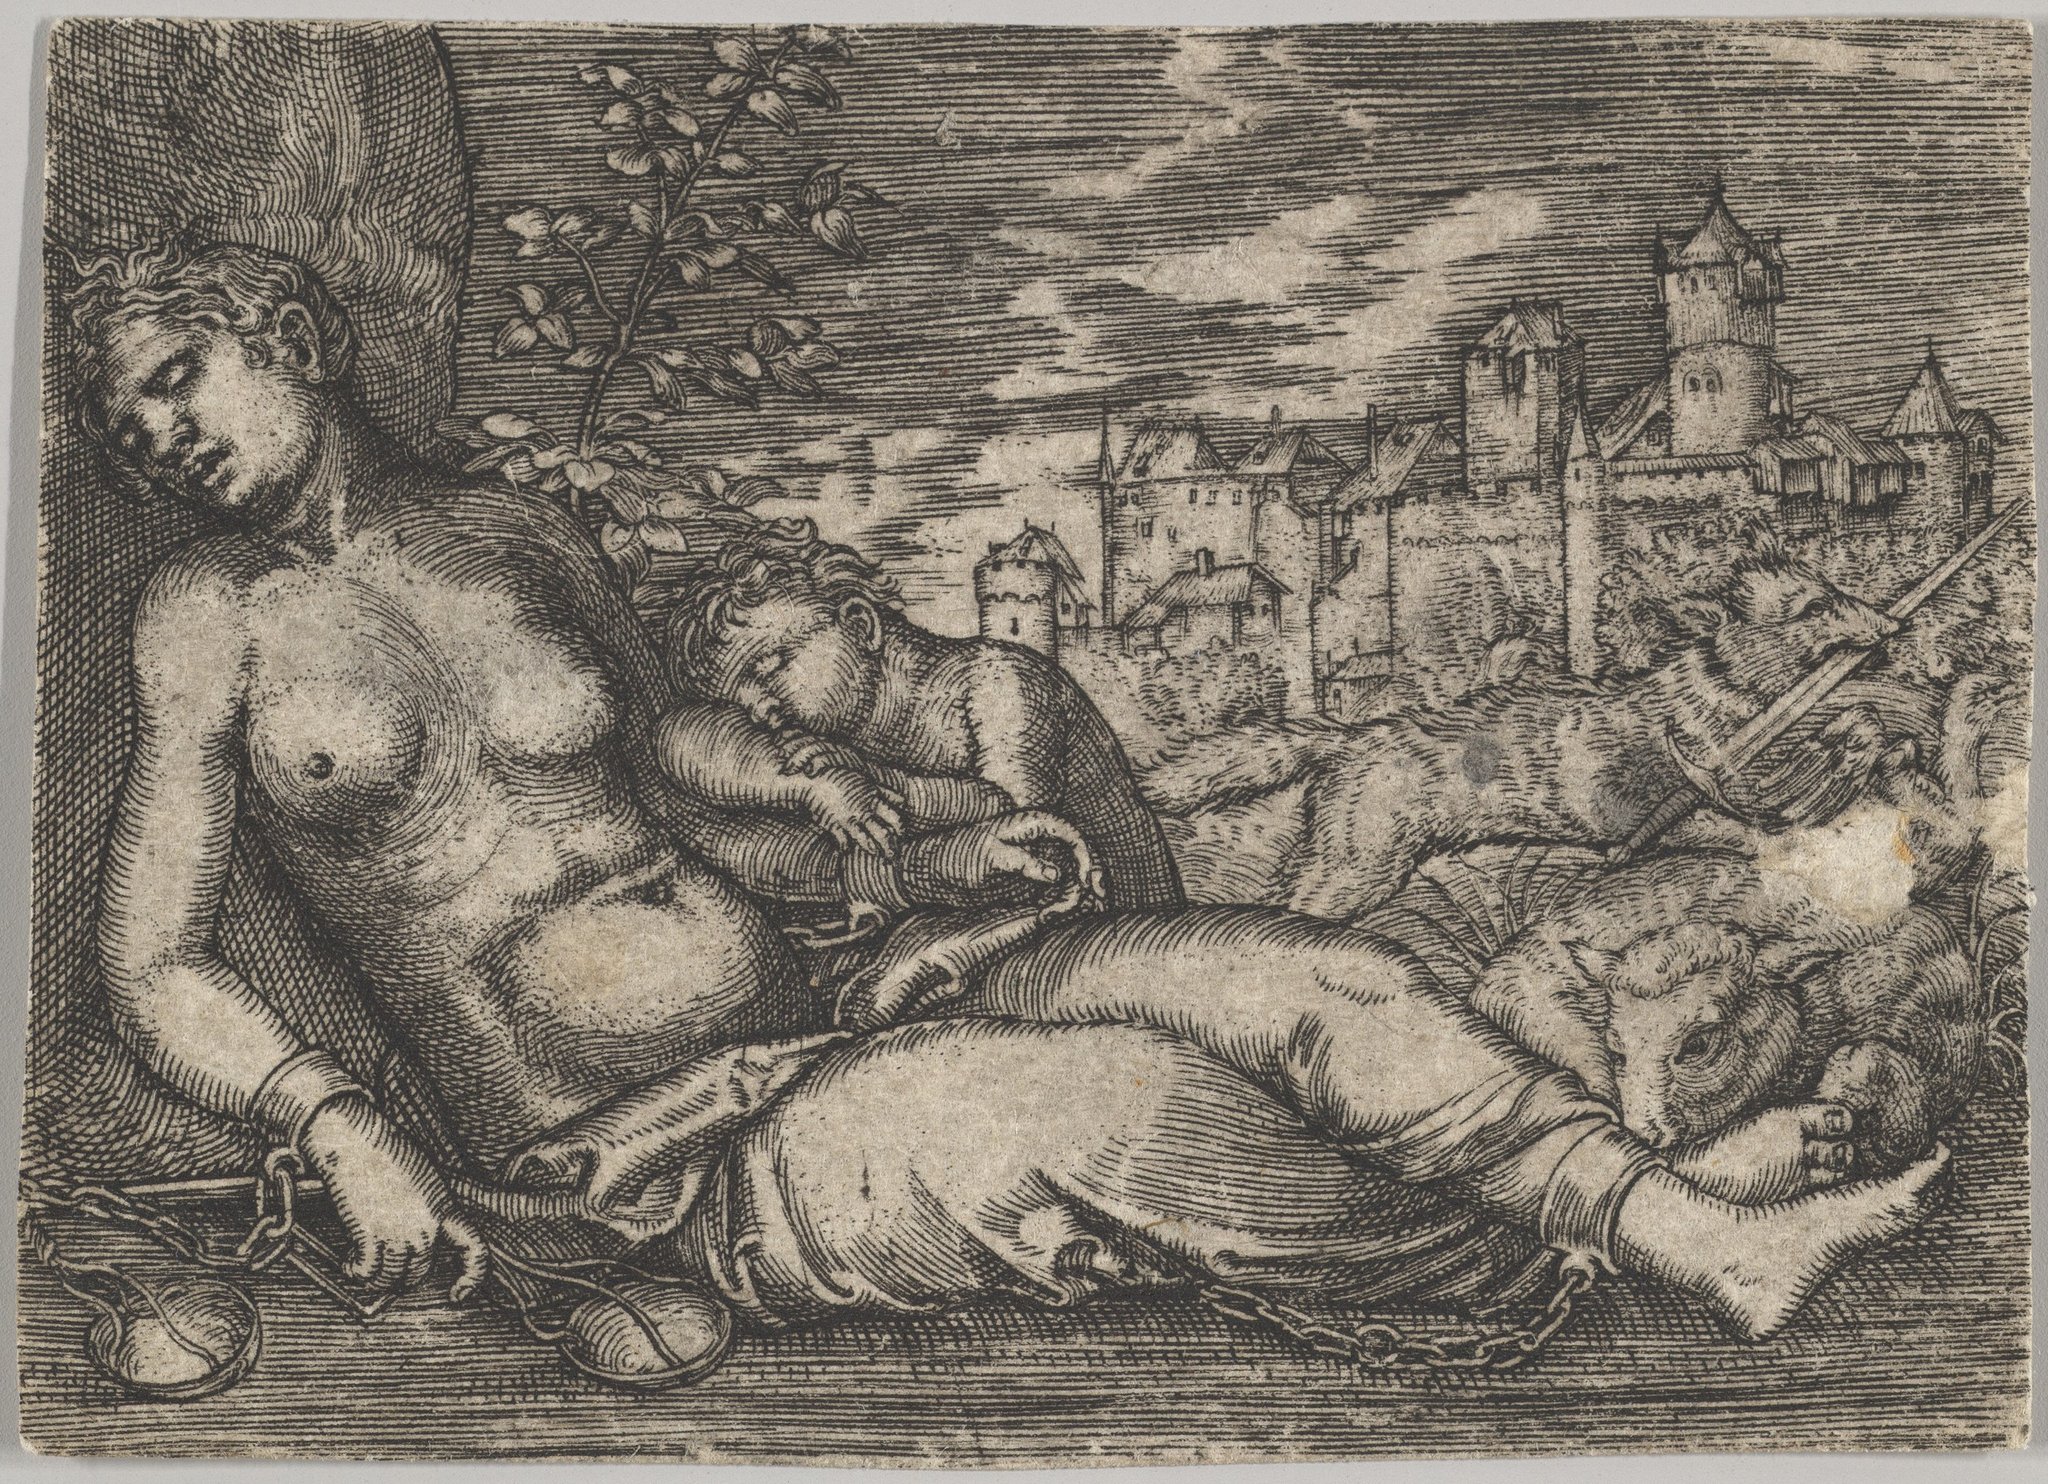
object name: print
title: Der Welt Lauf (Sleeping Justice) (copy)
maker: barthel beham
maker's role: artist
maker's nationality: german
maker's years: 1502-1540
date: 1501-1533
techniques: engraving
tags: animals,sleeping,children,female nudes